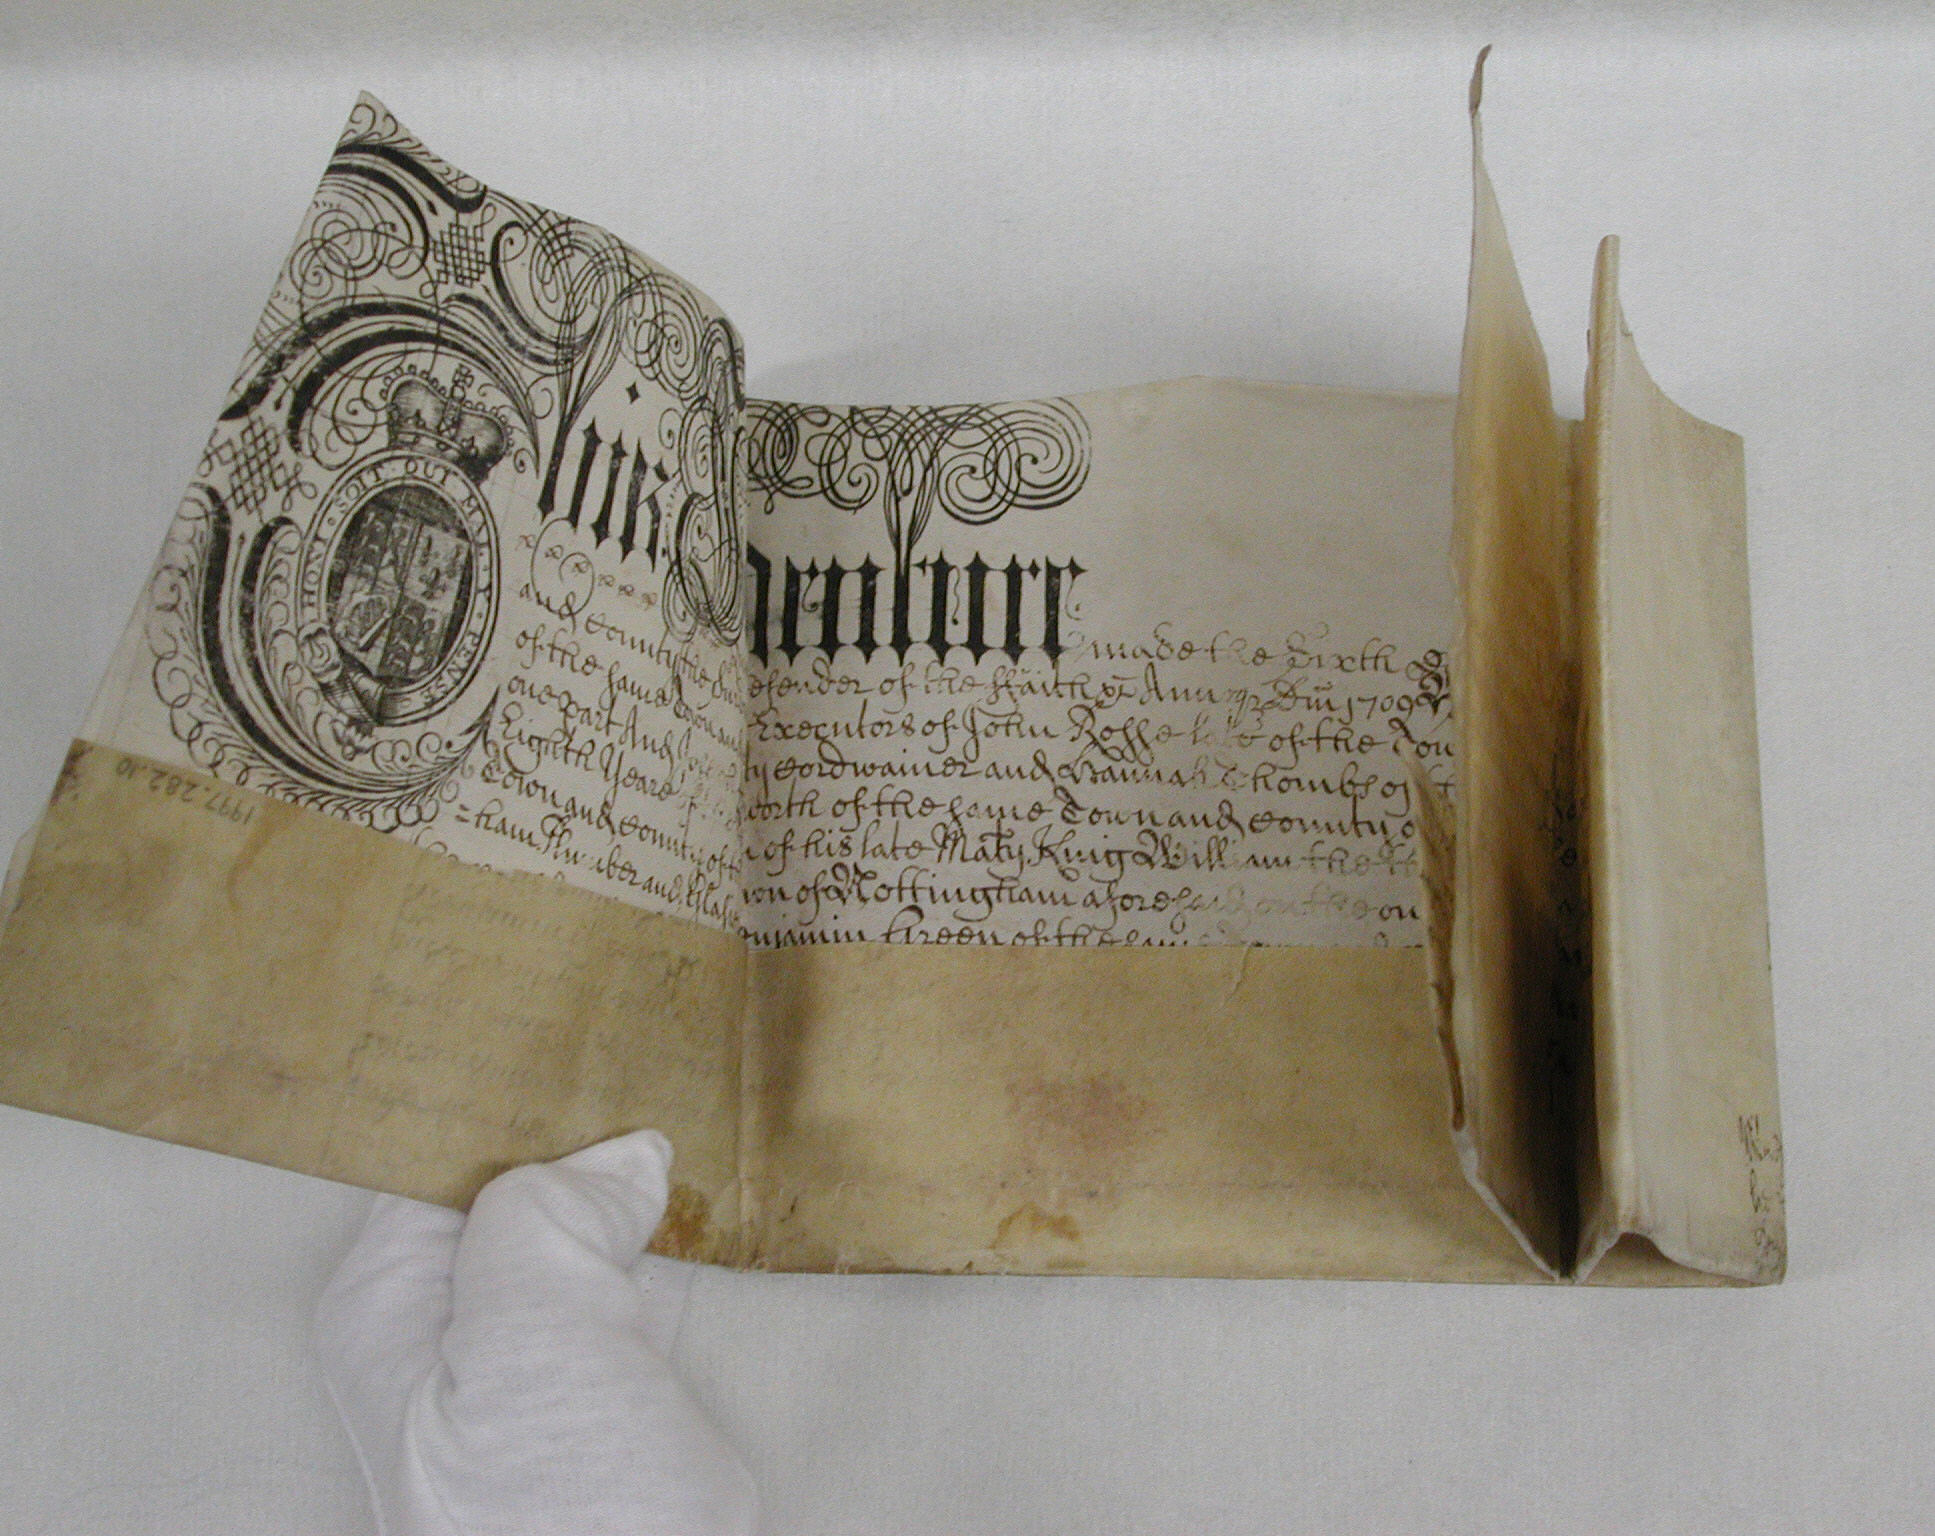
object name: indenture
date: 1701-1800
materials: parchment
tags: documents